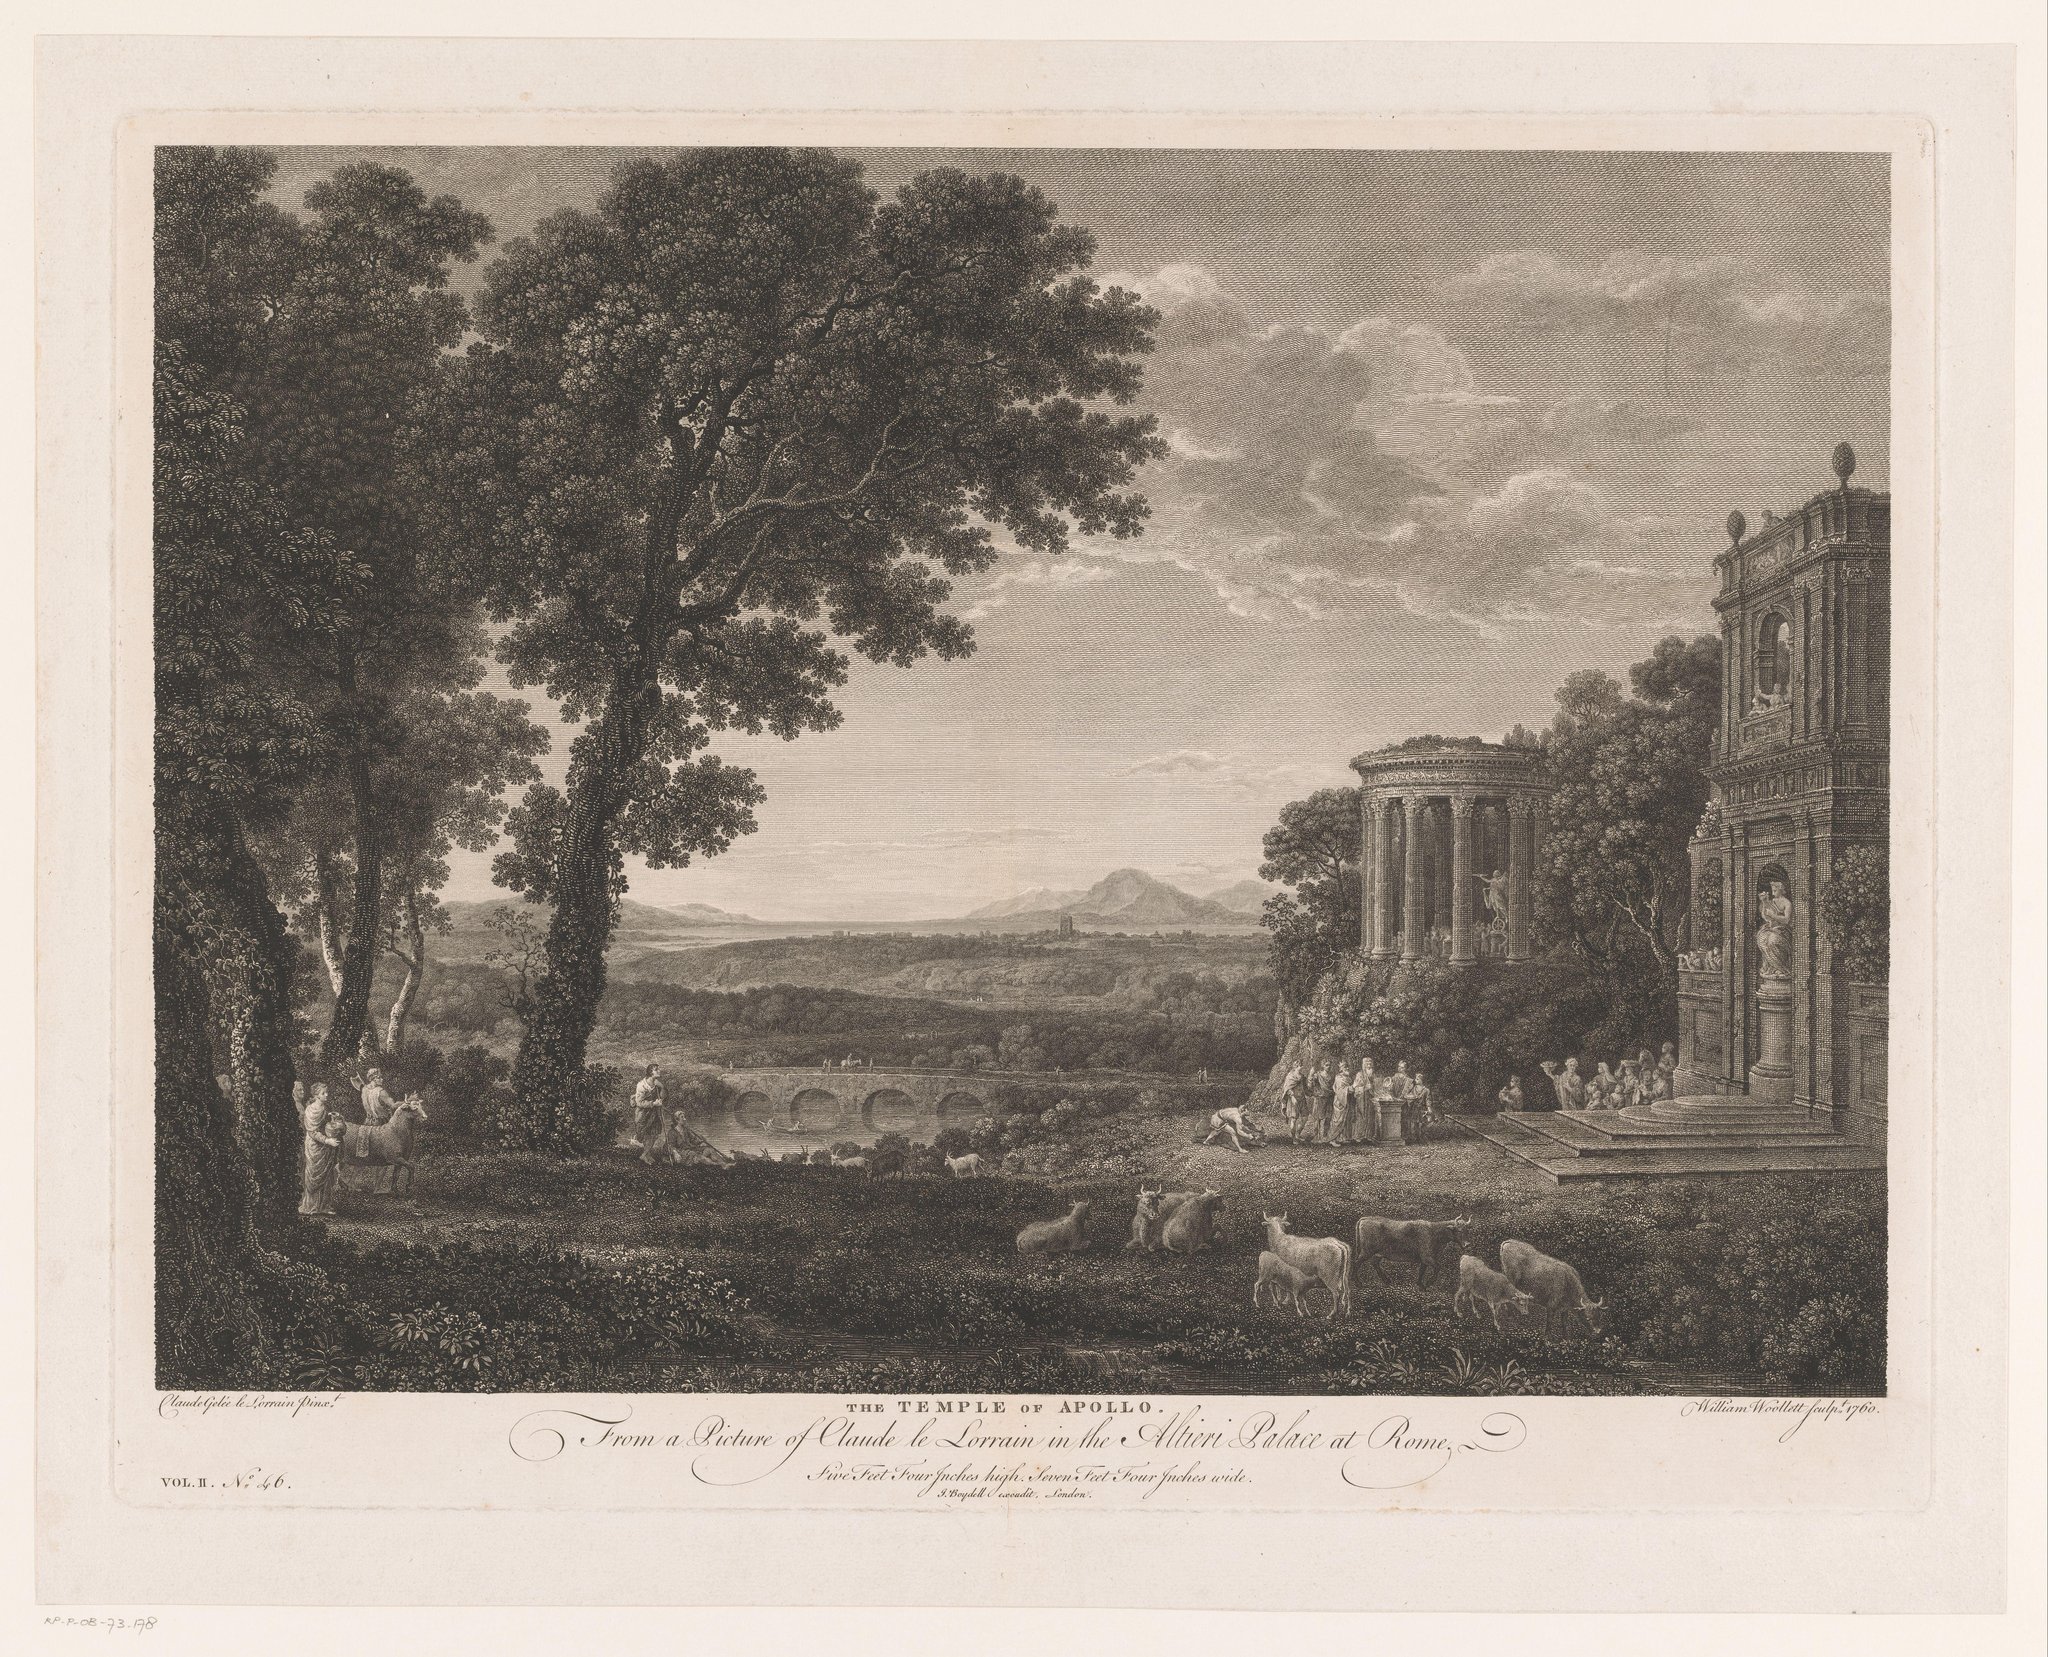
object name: print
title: The Temple of Apollo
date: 1760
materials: paper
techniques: etching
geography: england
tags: (story of) apollo (phoebus), animal sacrifice ~ roman religion, temple, shrine ~ roman religion, psyche's father consults the oracle, bovine cattle, landscape with bridge, viaduct or aqueduct - ii - ideal landscapes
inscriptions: inscription: ‘Schep: s oxc-:’, collector's mark: Lugt 12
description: Prent is mogelijk onderdeel van de serie 'Most Capital Paintings in England'.